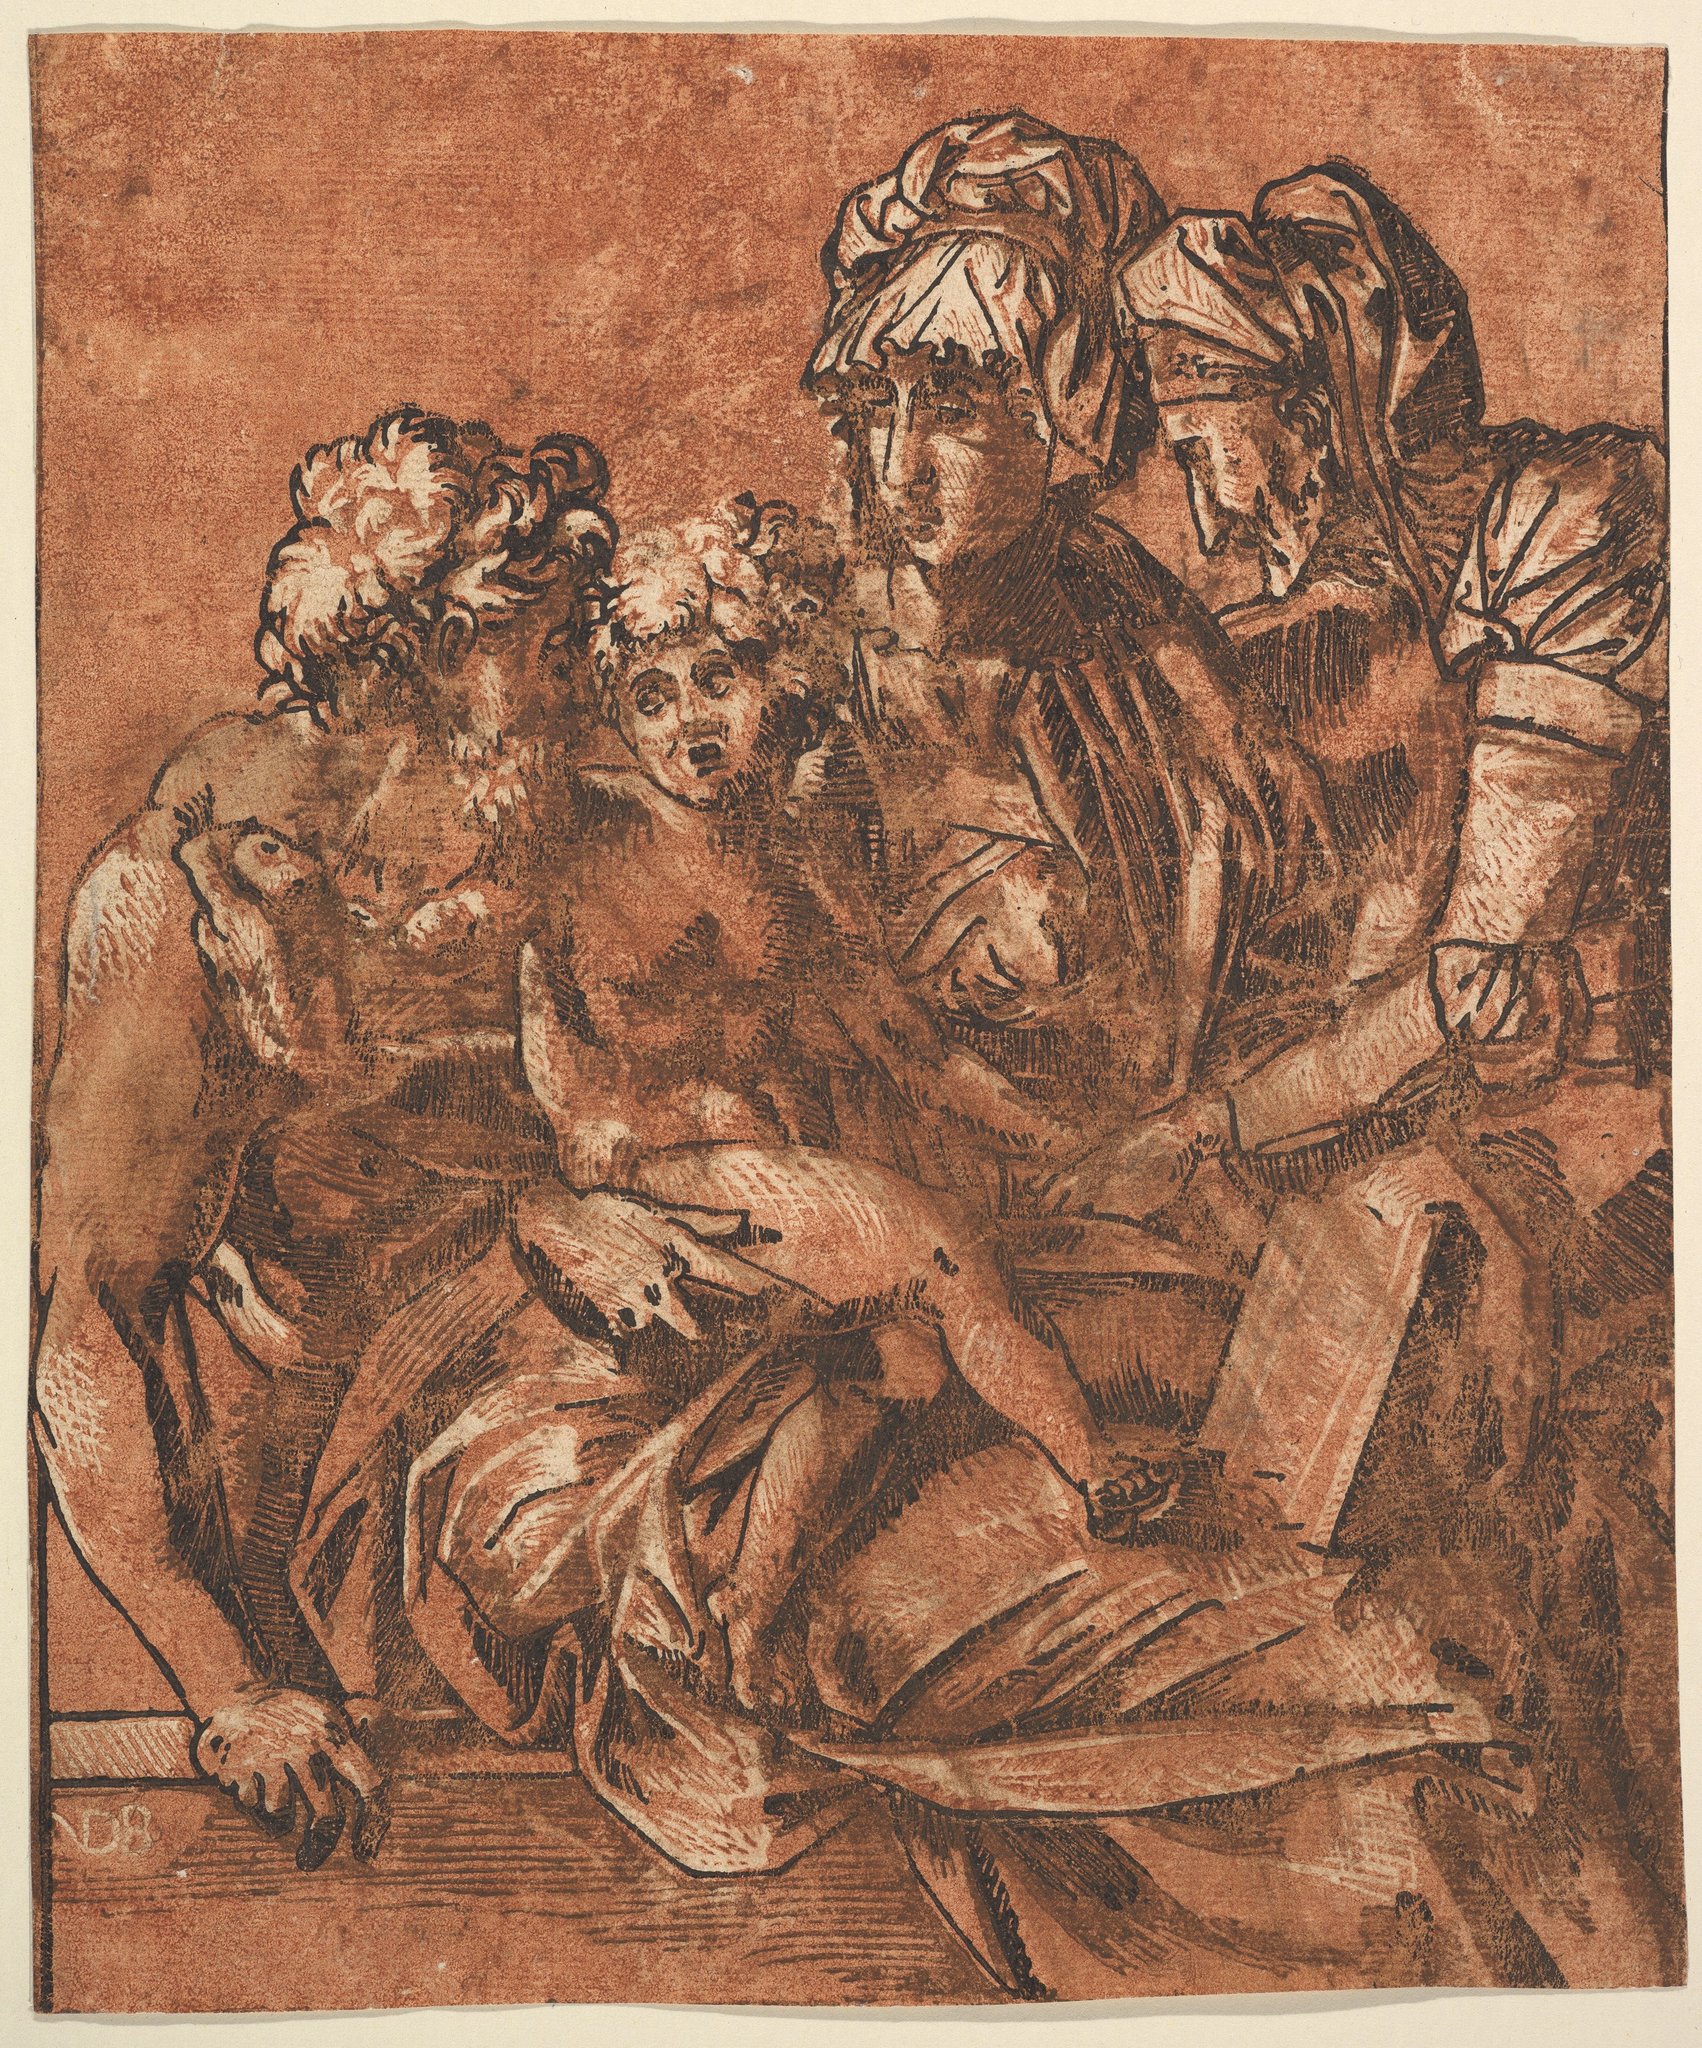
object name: print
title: Holy Family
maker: master nd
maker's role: artist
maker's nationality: italian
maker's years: 1540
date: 1544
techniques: woodcut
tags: holy family